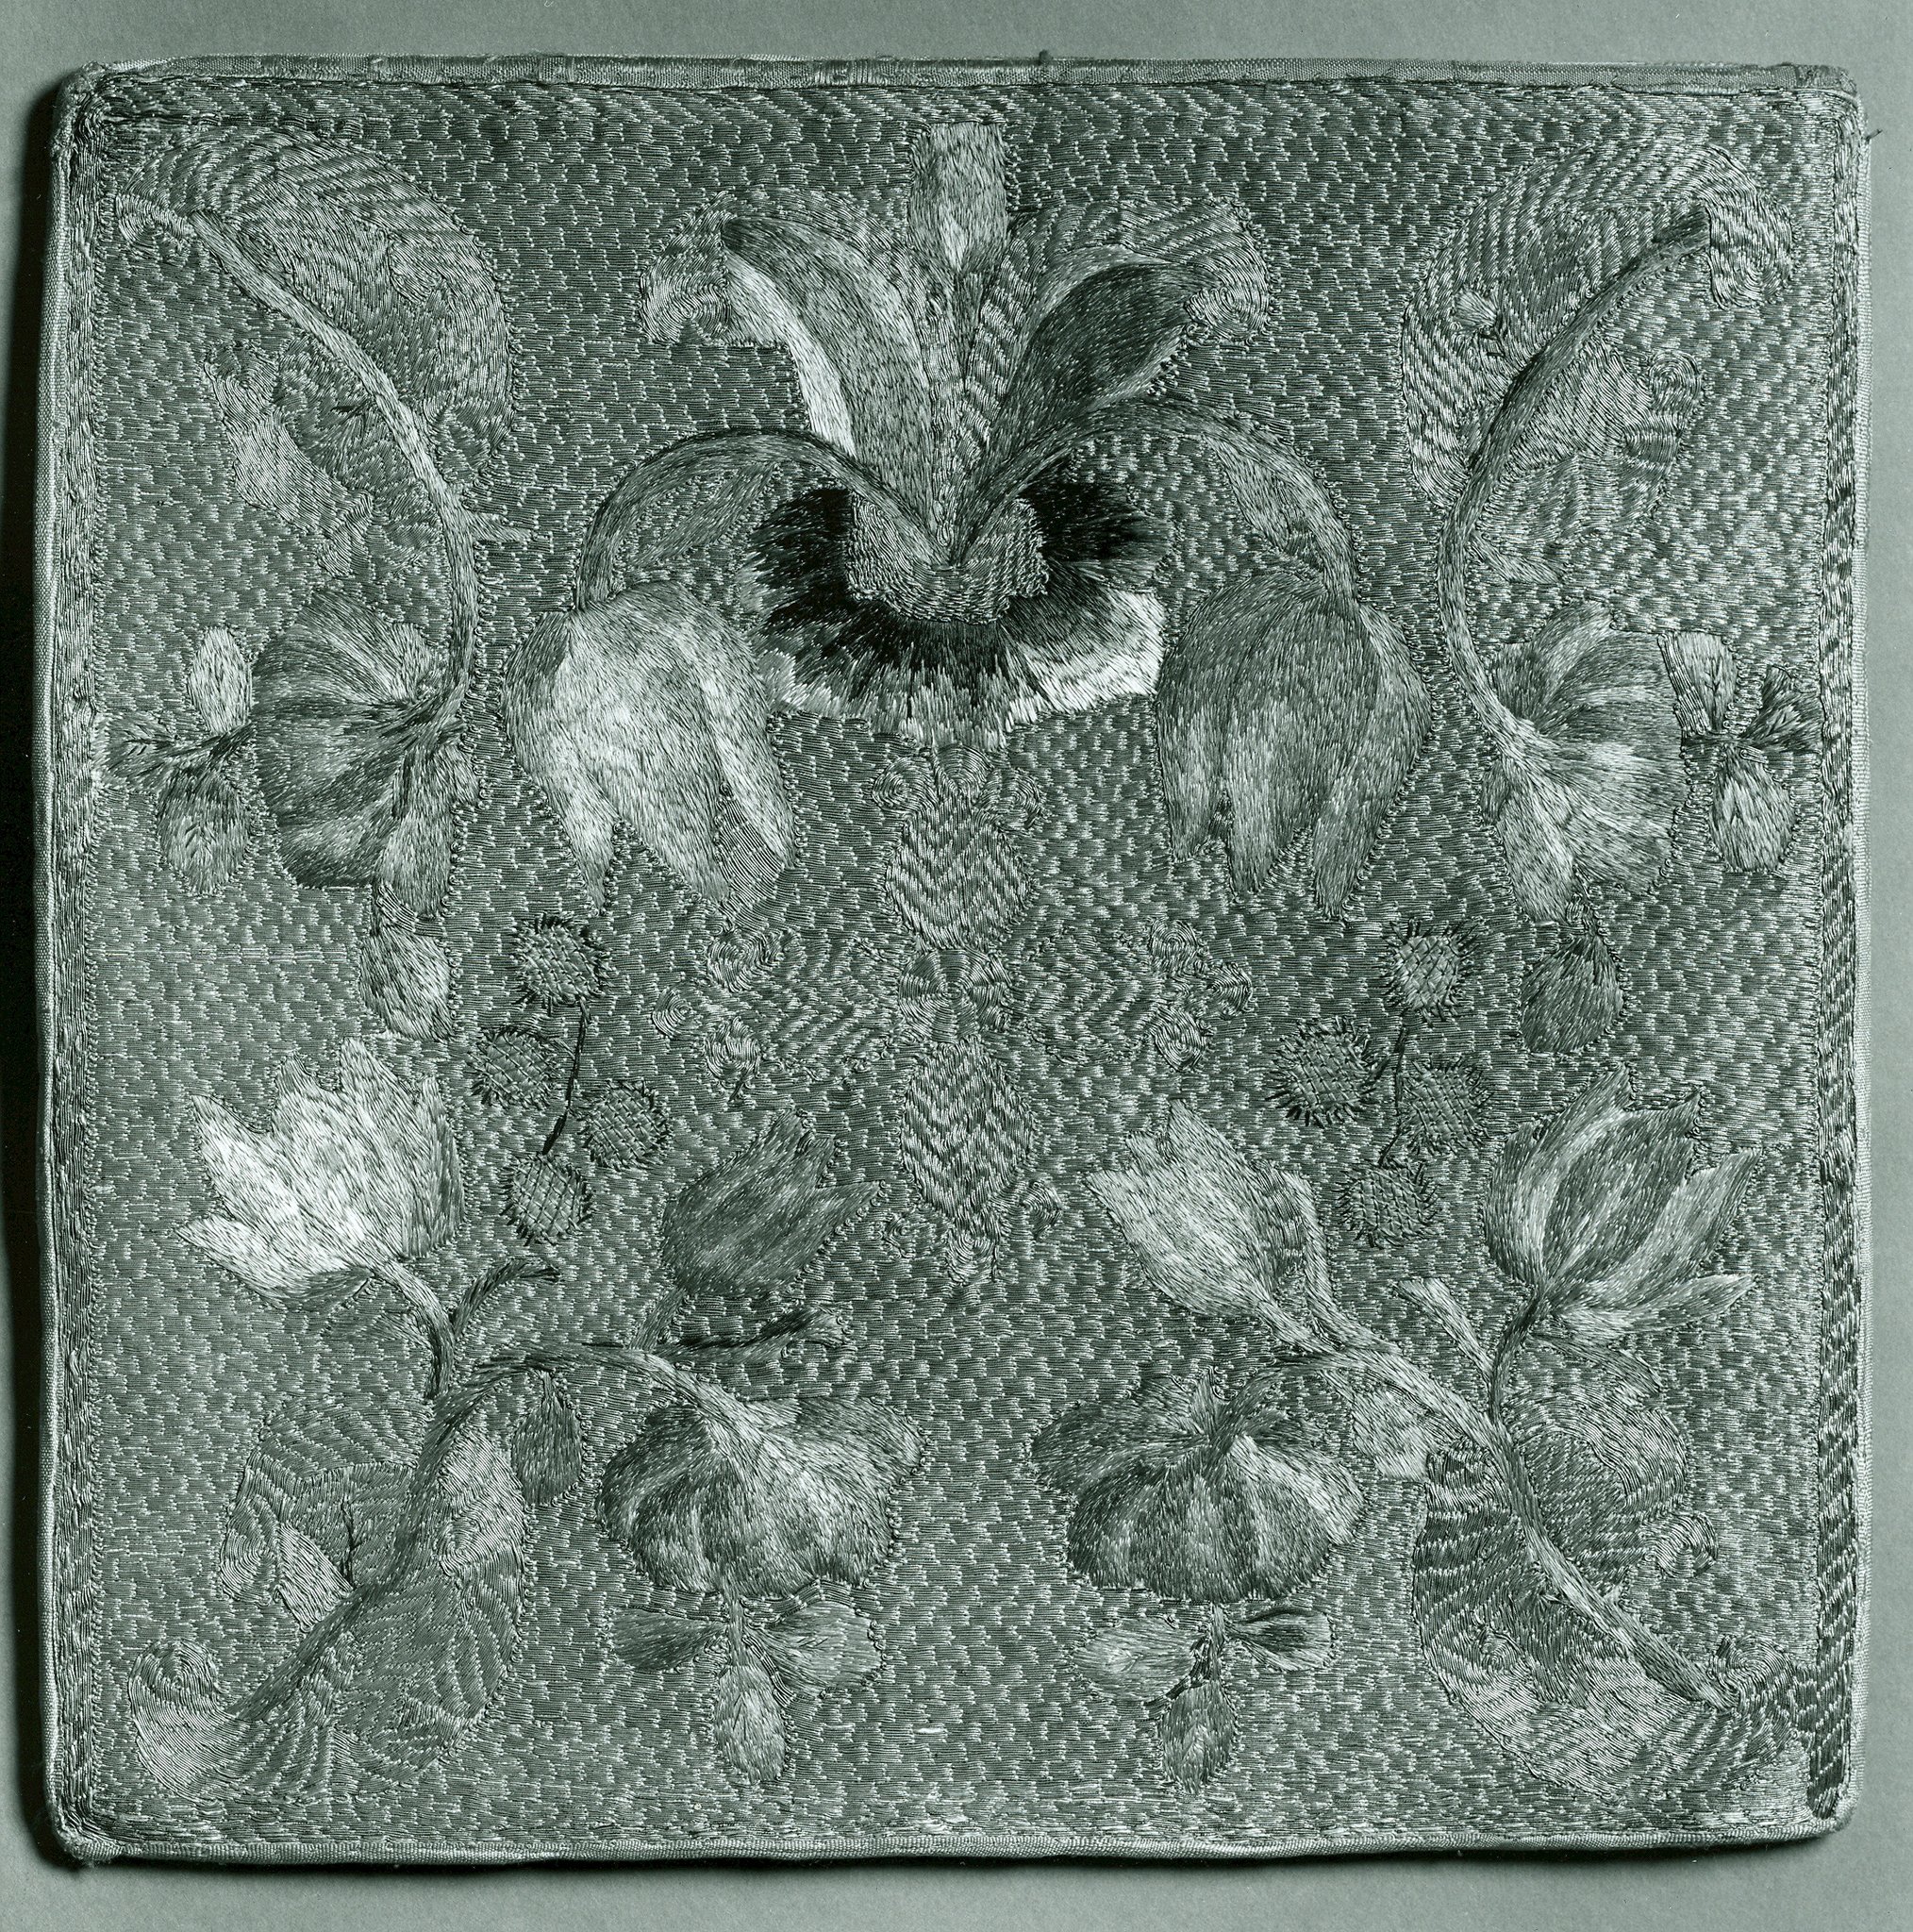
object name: burse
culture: italian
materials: linen, metal, silk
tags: flowers